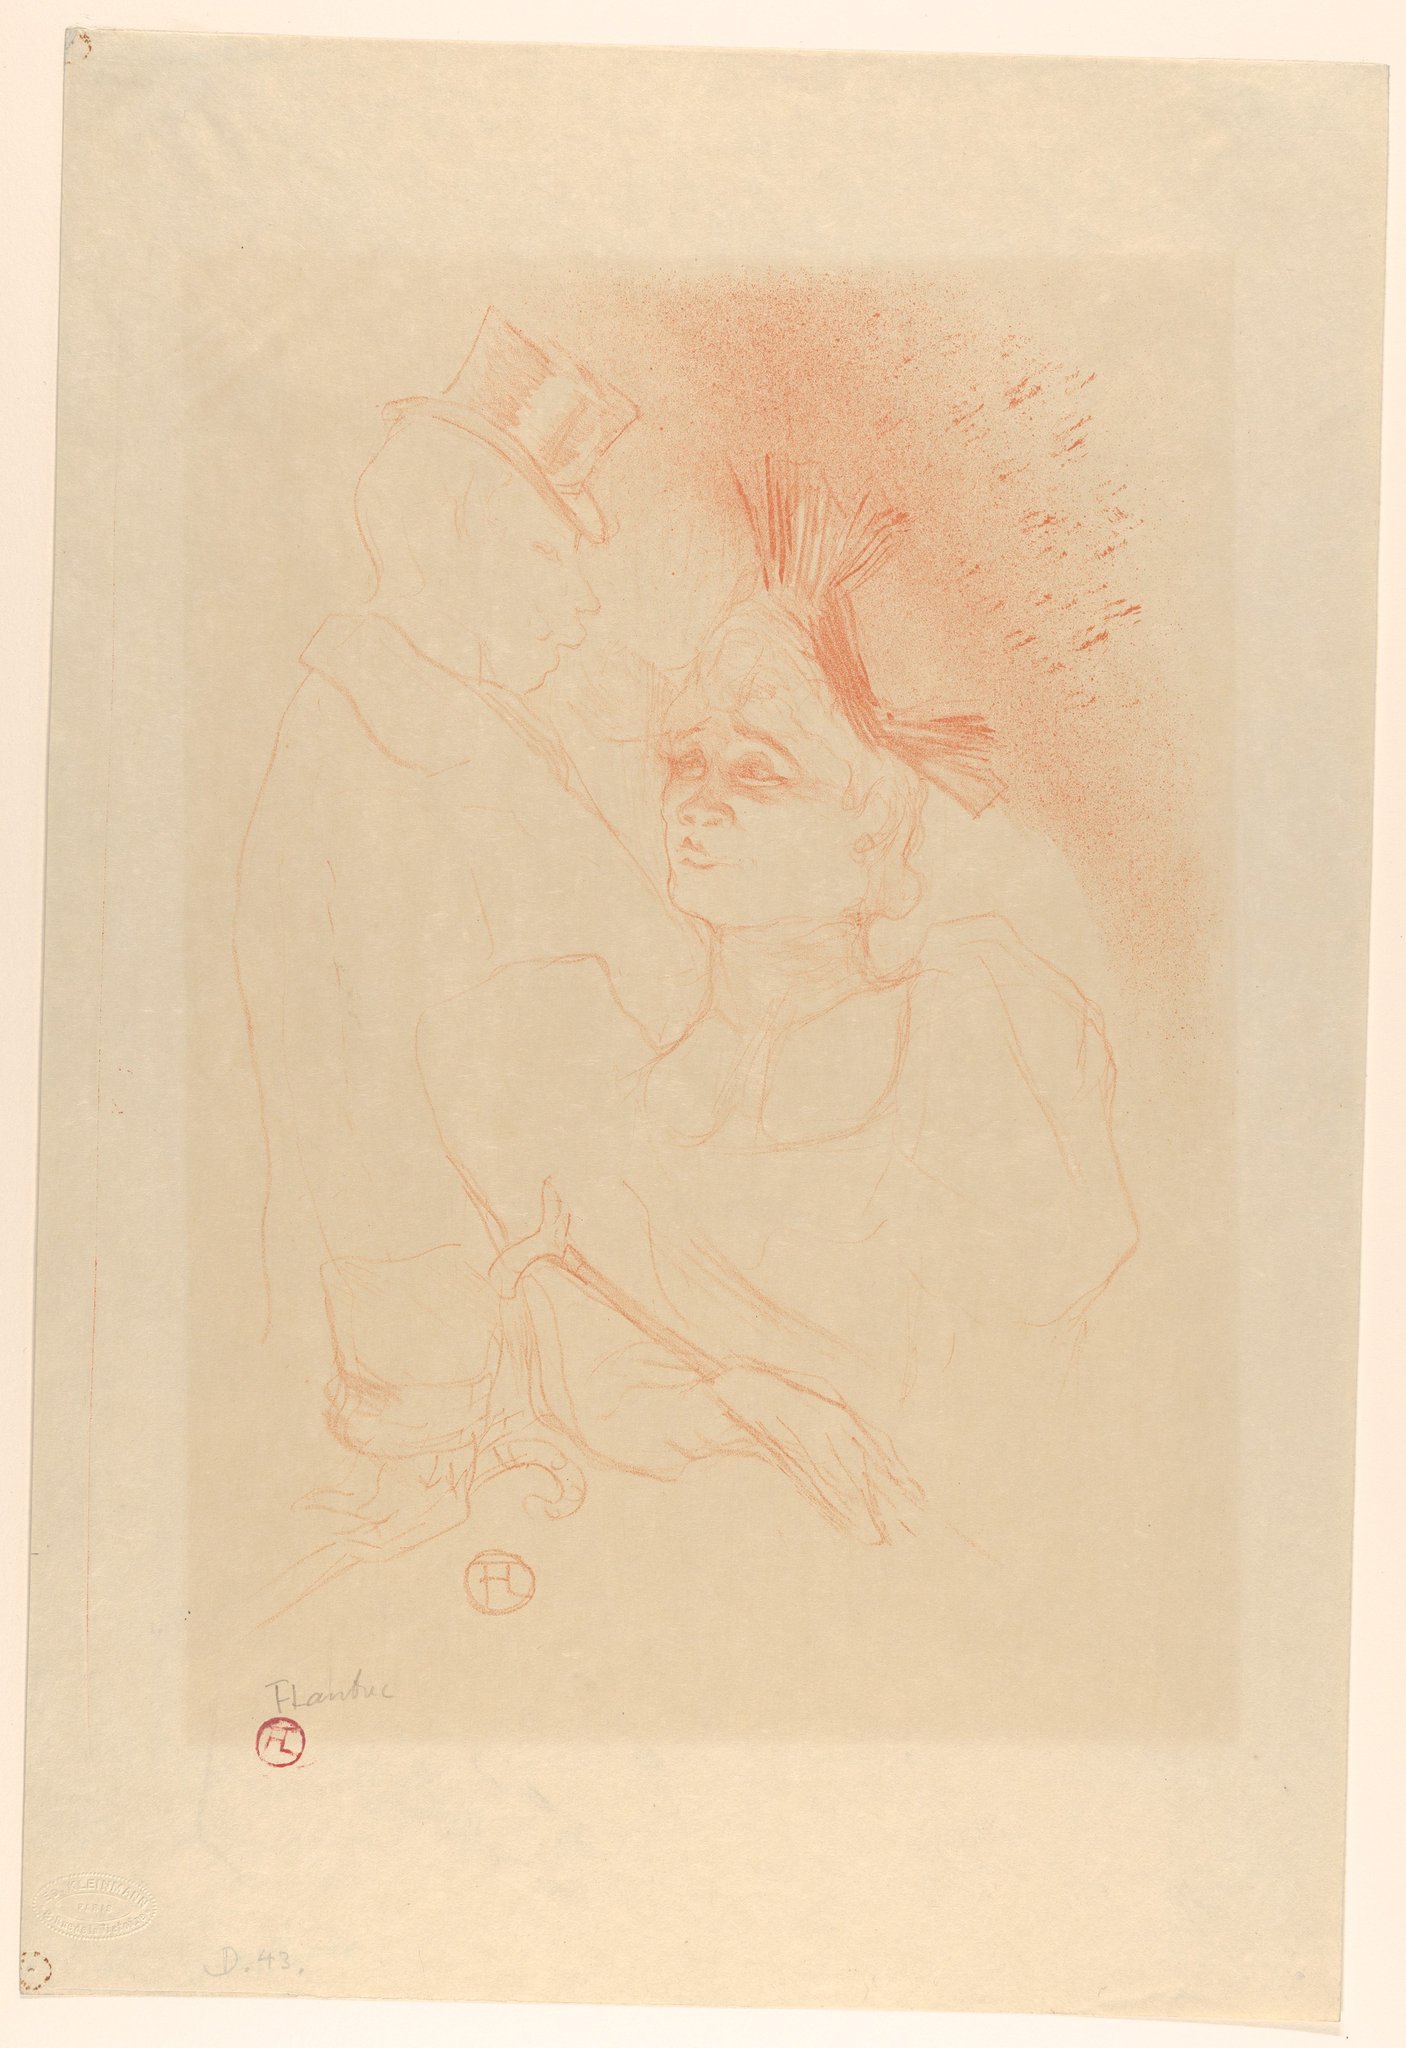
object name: print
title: Mademoiselle Lender and Baron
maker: henri de toulouse-lautrec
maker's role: artist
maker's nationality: french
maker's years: 1864-1901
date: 1893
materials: crayon, paper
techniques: brush, lithograph, printing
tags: men,women